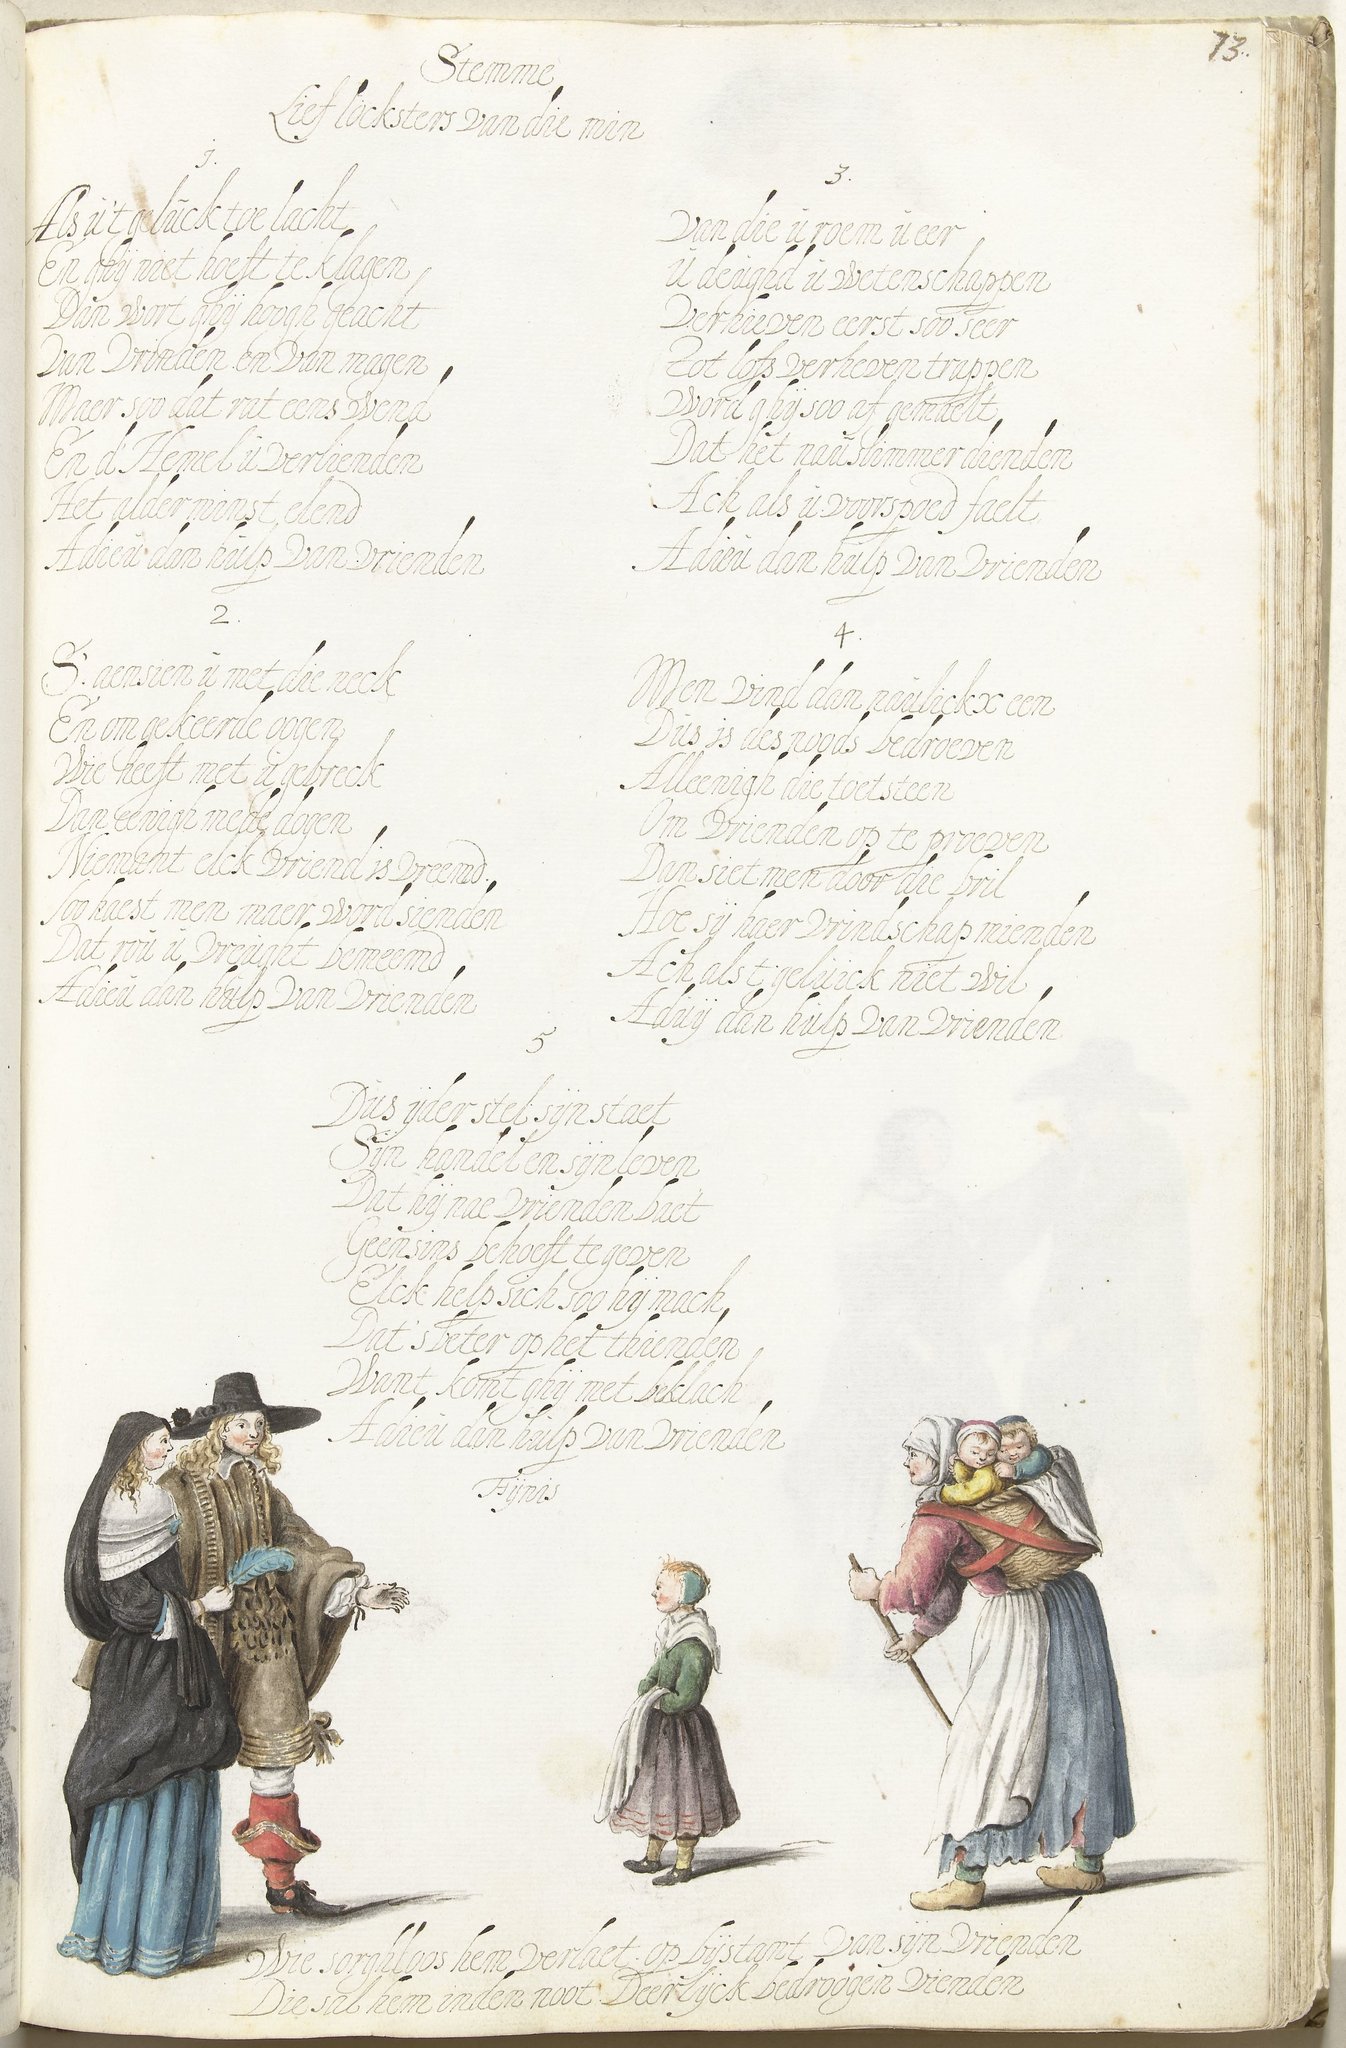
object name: poem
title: Heer en een dame staand voor een arme moeder en haar kinderen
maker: gesina ter borch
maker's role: draughtsman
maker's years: 1633-1690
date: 1654-1655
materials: ink, paper, watercolor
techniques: brush, calligraphy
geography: zwolle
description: Het gedicht is afkomstig van Jan Starter, die het publiceerde met muziek in zijn Friesche Lust-hof uit 1621 (het gedicht op p. 94f en de muziek op p. 73f, dezelfde melodie als hier). De voorstelling van de arme vrouw met kinderen is ook afgebeeld op folio 155a van het Familie-Plakboek van Gesina.